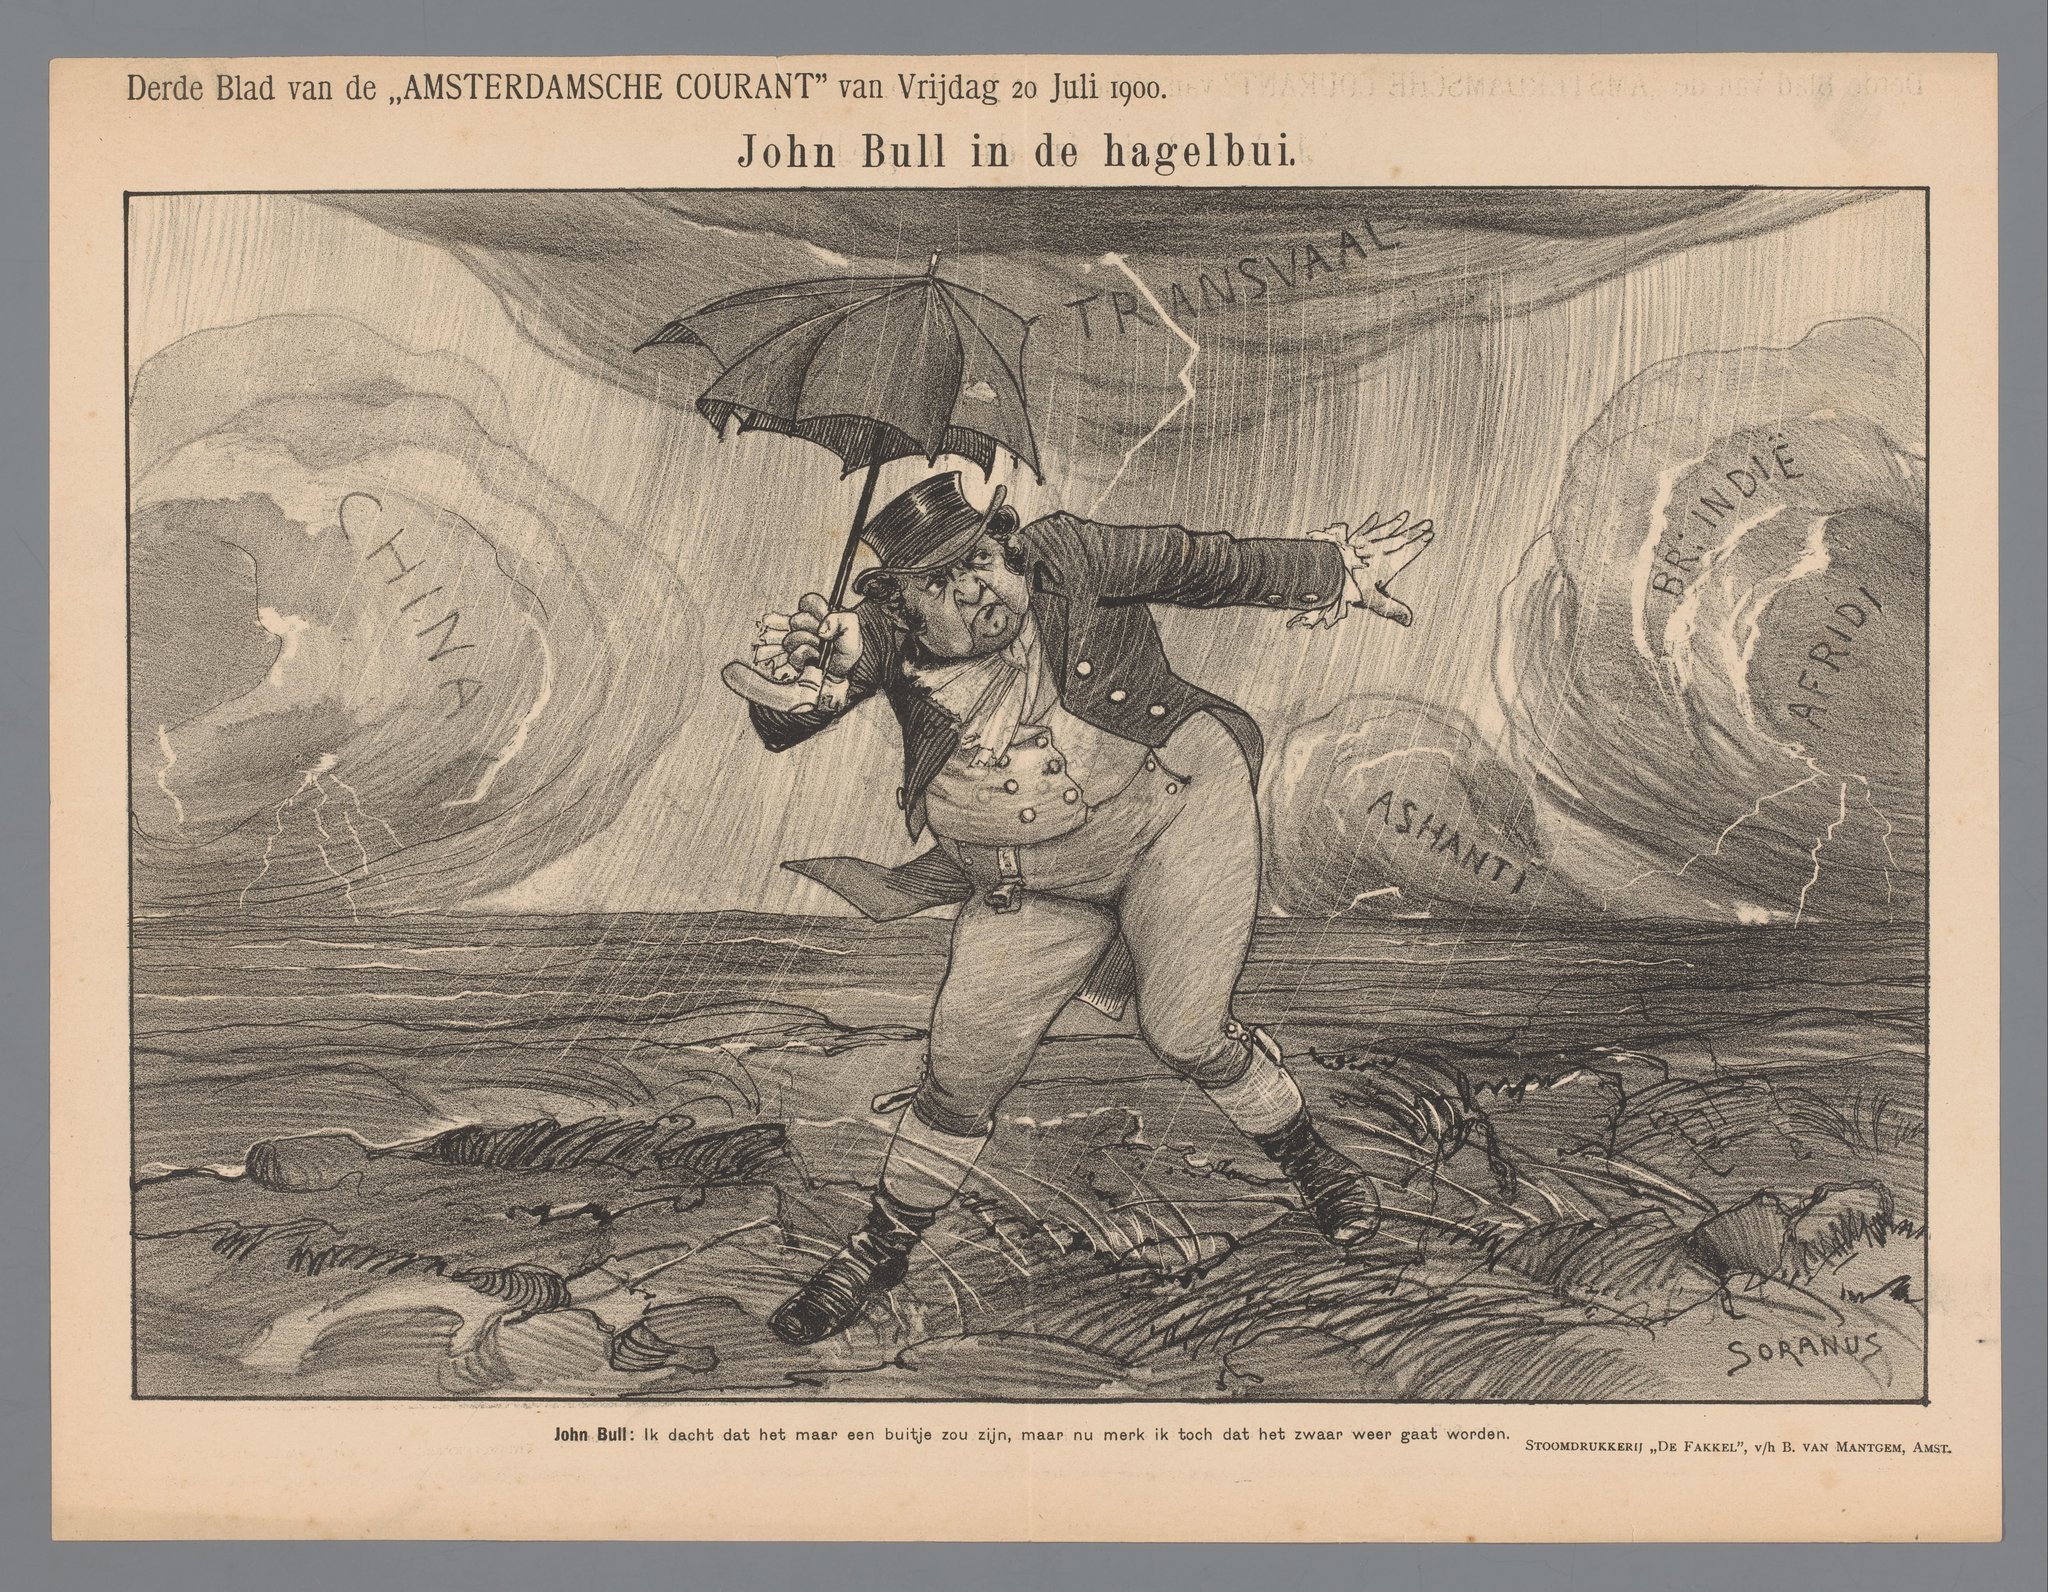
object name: cartoon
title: John Bull in de hagelbui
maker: petrus van geldorp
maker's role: draughtsman, print maker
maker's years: 1872-1939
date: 1900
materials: paper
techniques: lithograph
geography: amsterdam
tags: personifications of countries, nations, states, districts, etc., storm at sea, political caricatures and satires, united kingdom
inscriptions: date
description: Prent uit het bijvoegsel van: De Amsterdamsche Courant, 20 juli 1900.